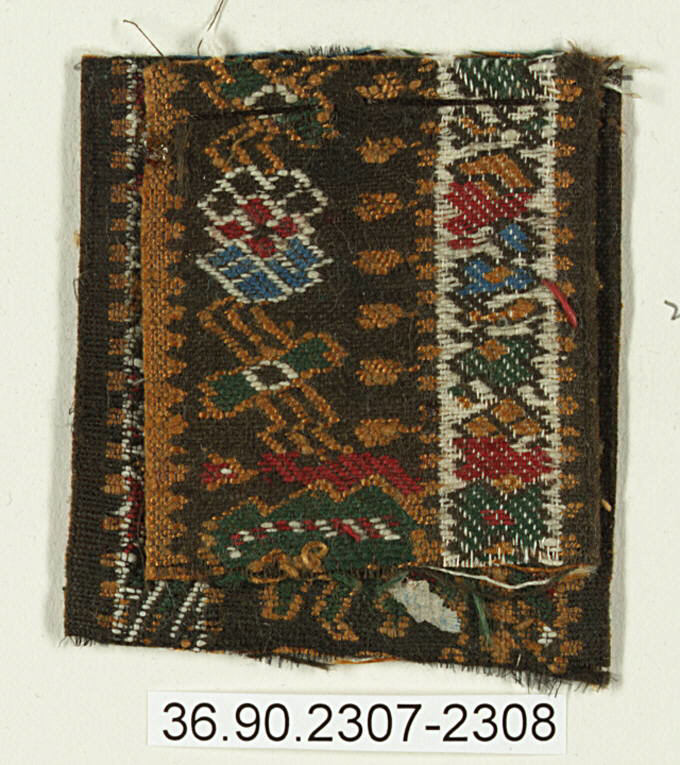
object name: border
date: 1801-1900